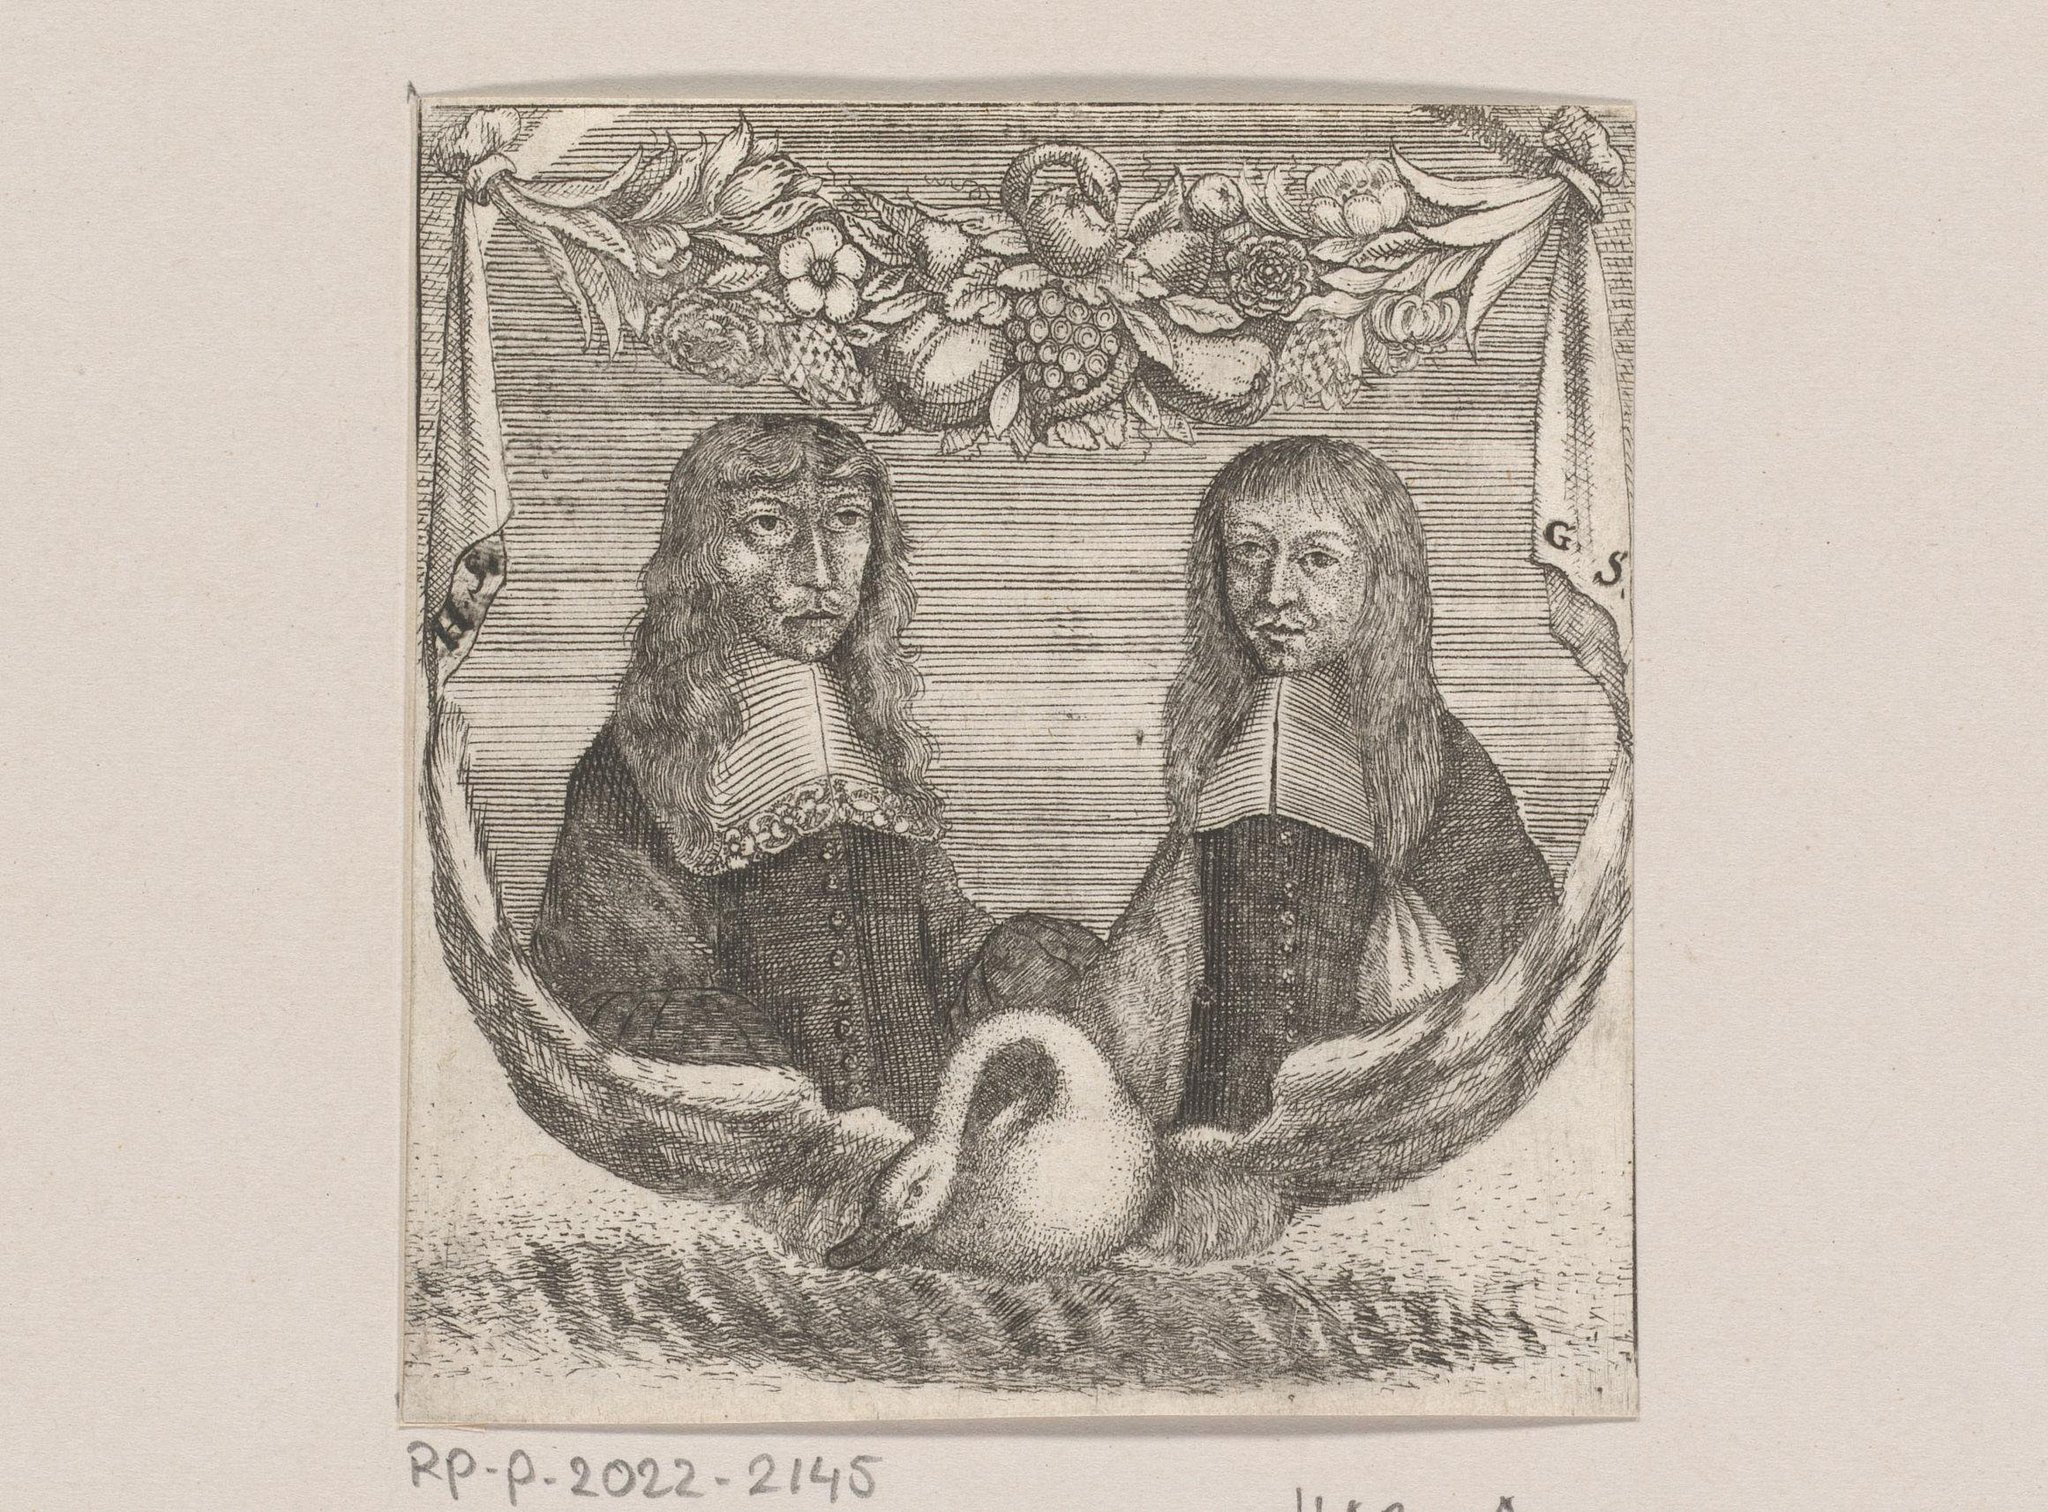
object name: print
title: Portretten van Georg Schwanhard II en Heinrich Schwanhard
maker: Anonymous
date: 1660-1699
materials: paper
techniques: engraving, etching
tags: engraver, etcher, historical person in a double portrait, other handicrafts ~ glass